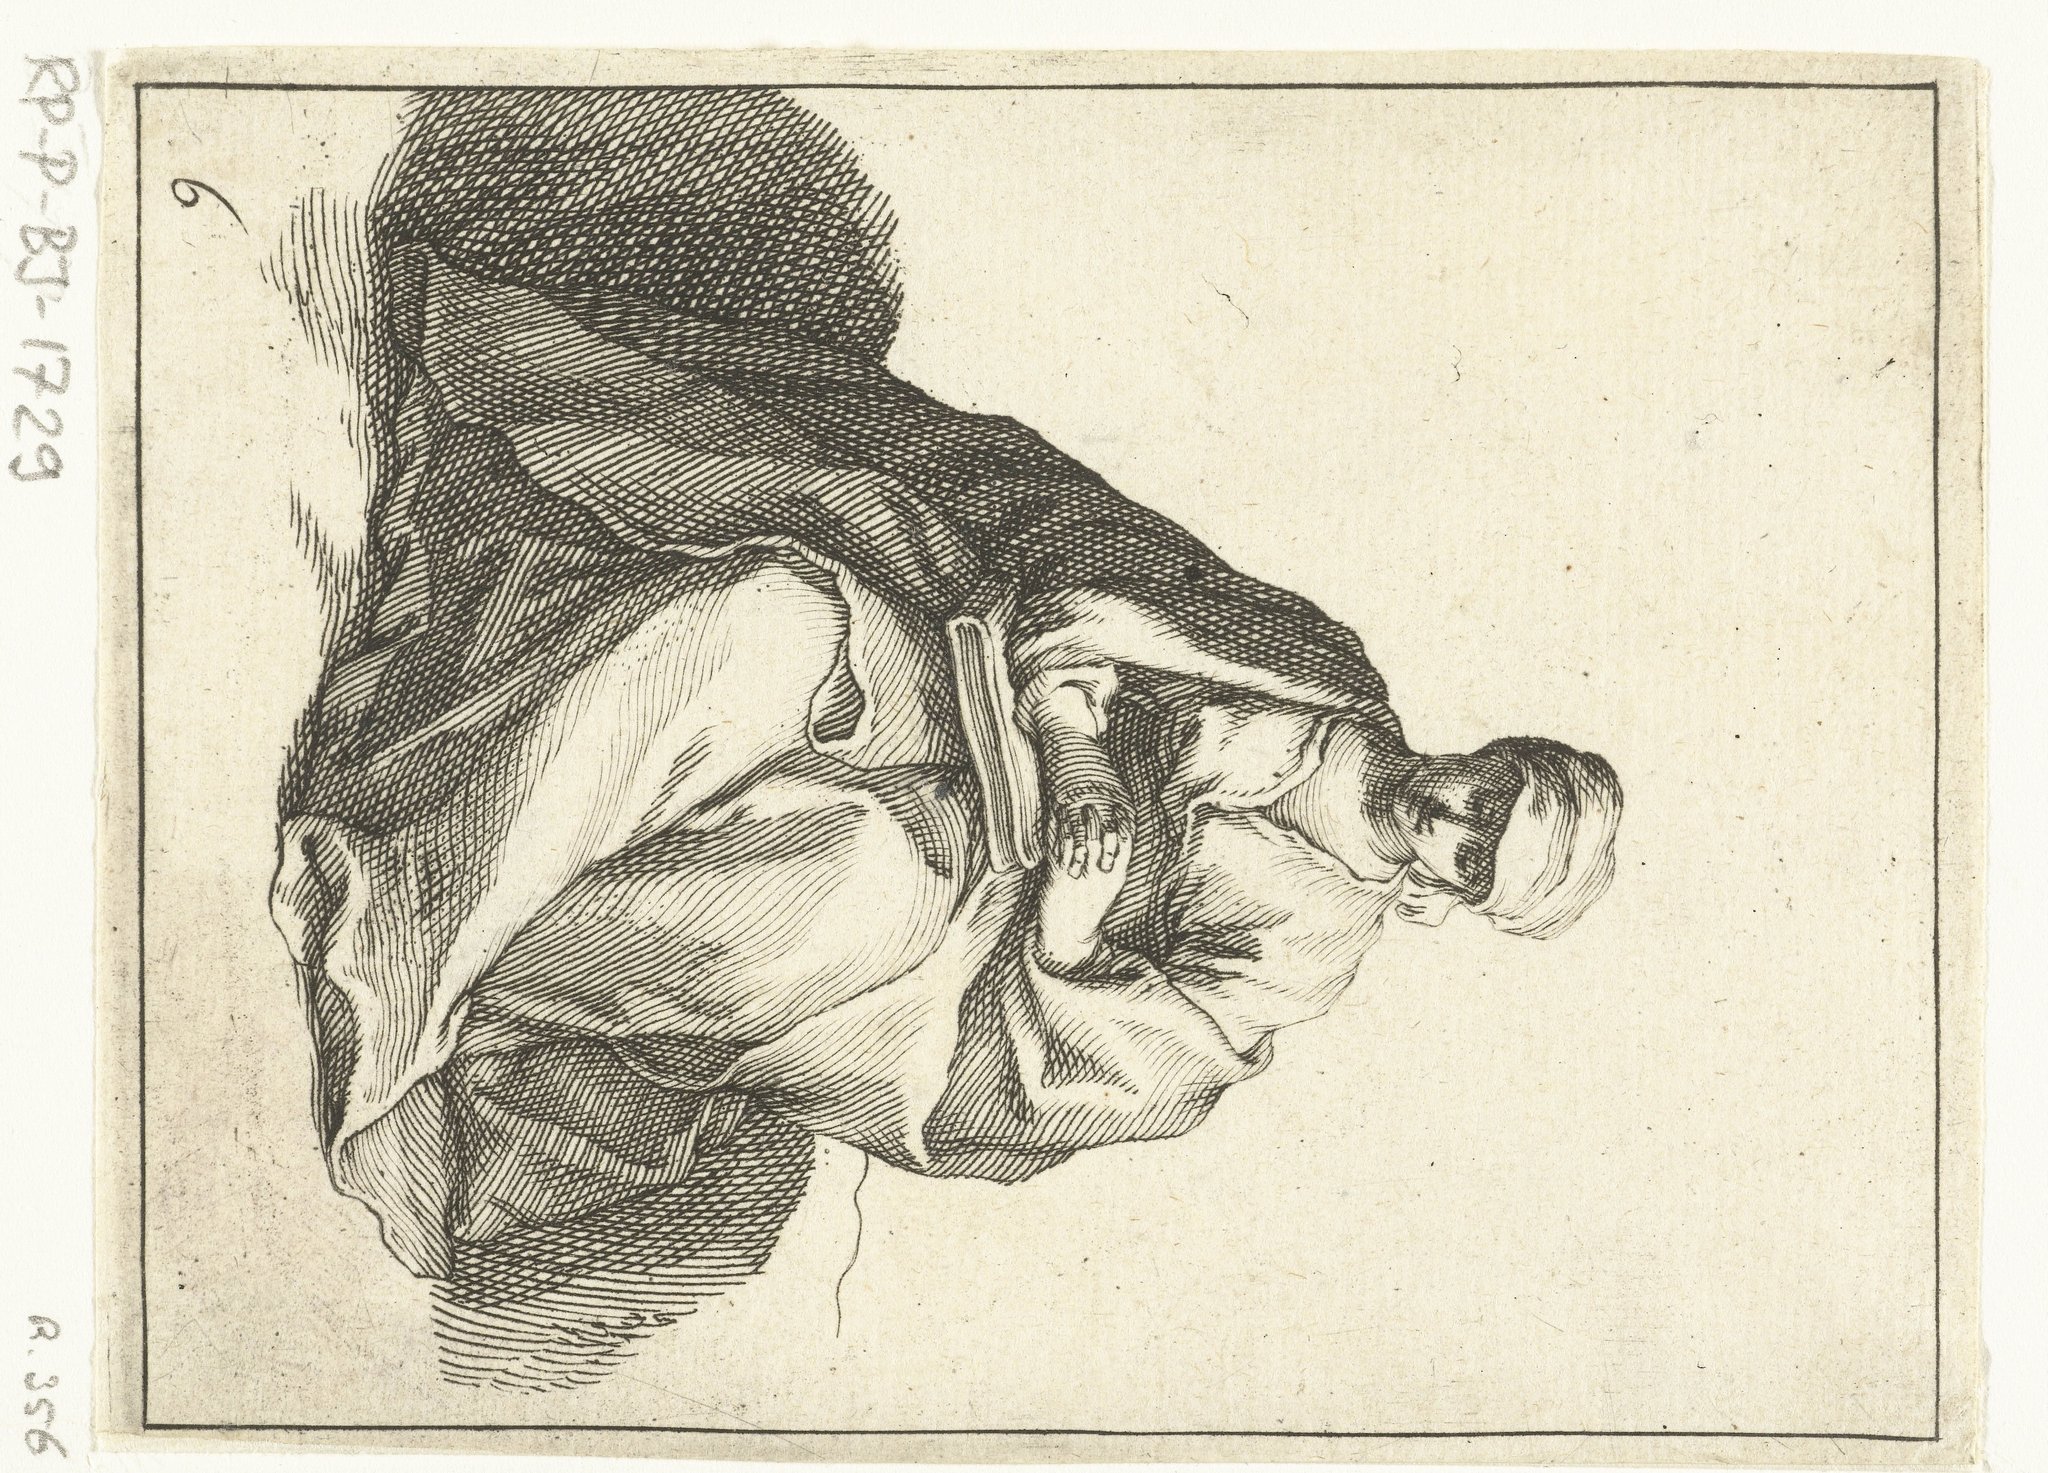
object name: print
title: Zittende, biddende vrouw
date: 1635-1669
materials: paper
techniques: engraving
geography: utrecht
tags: adult woman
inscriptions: collector's mark: Lugt 240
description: Een vrouw, vooraanzicht, zit met een boek op haar schoot en de handen in gebed gevouwen.